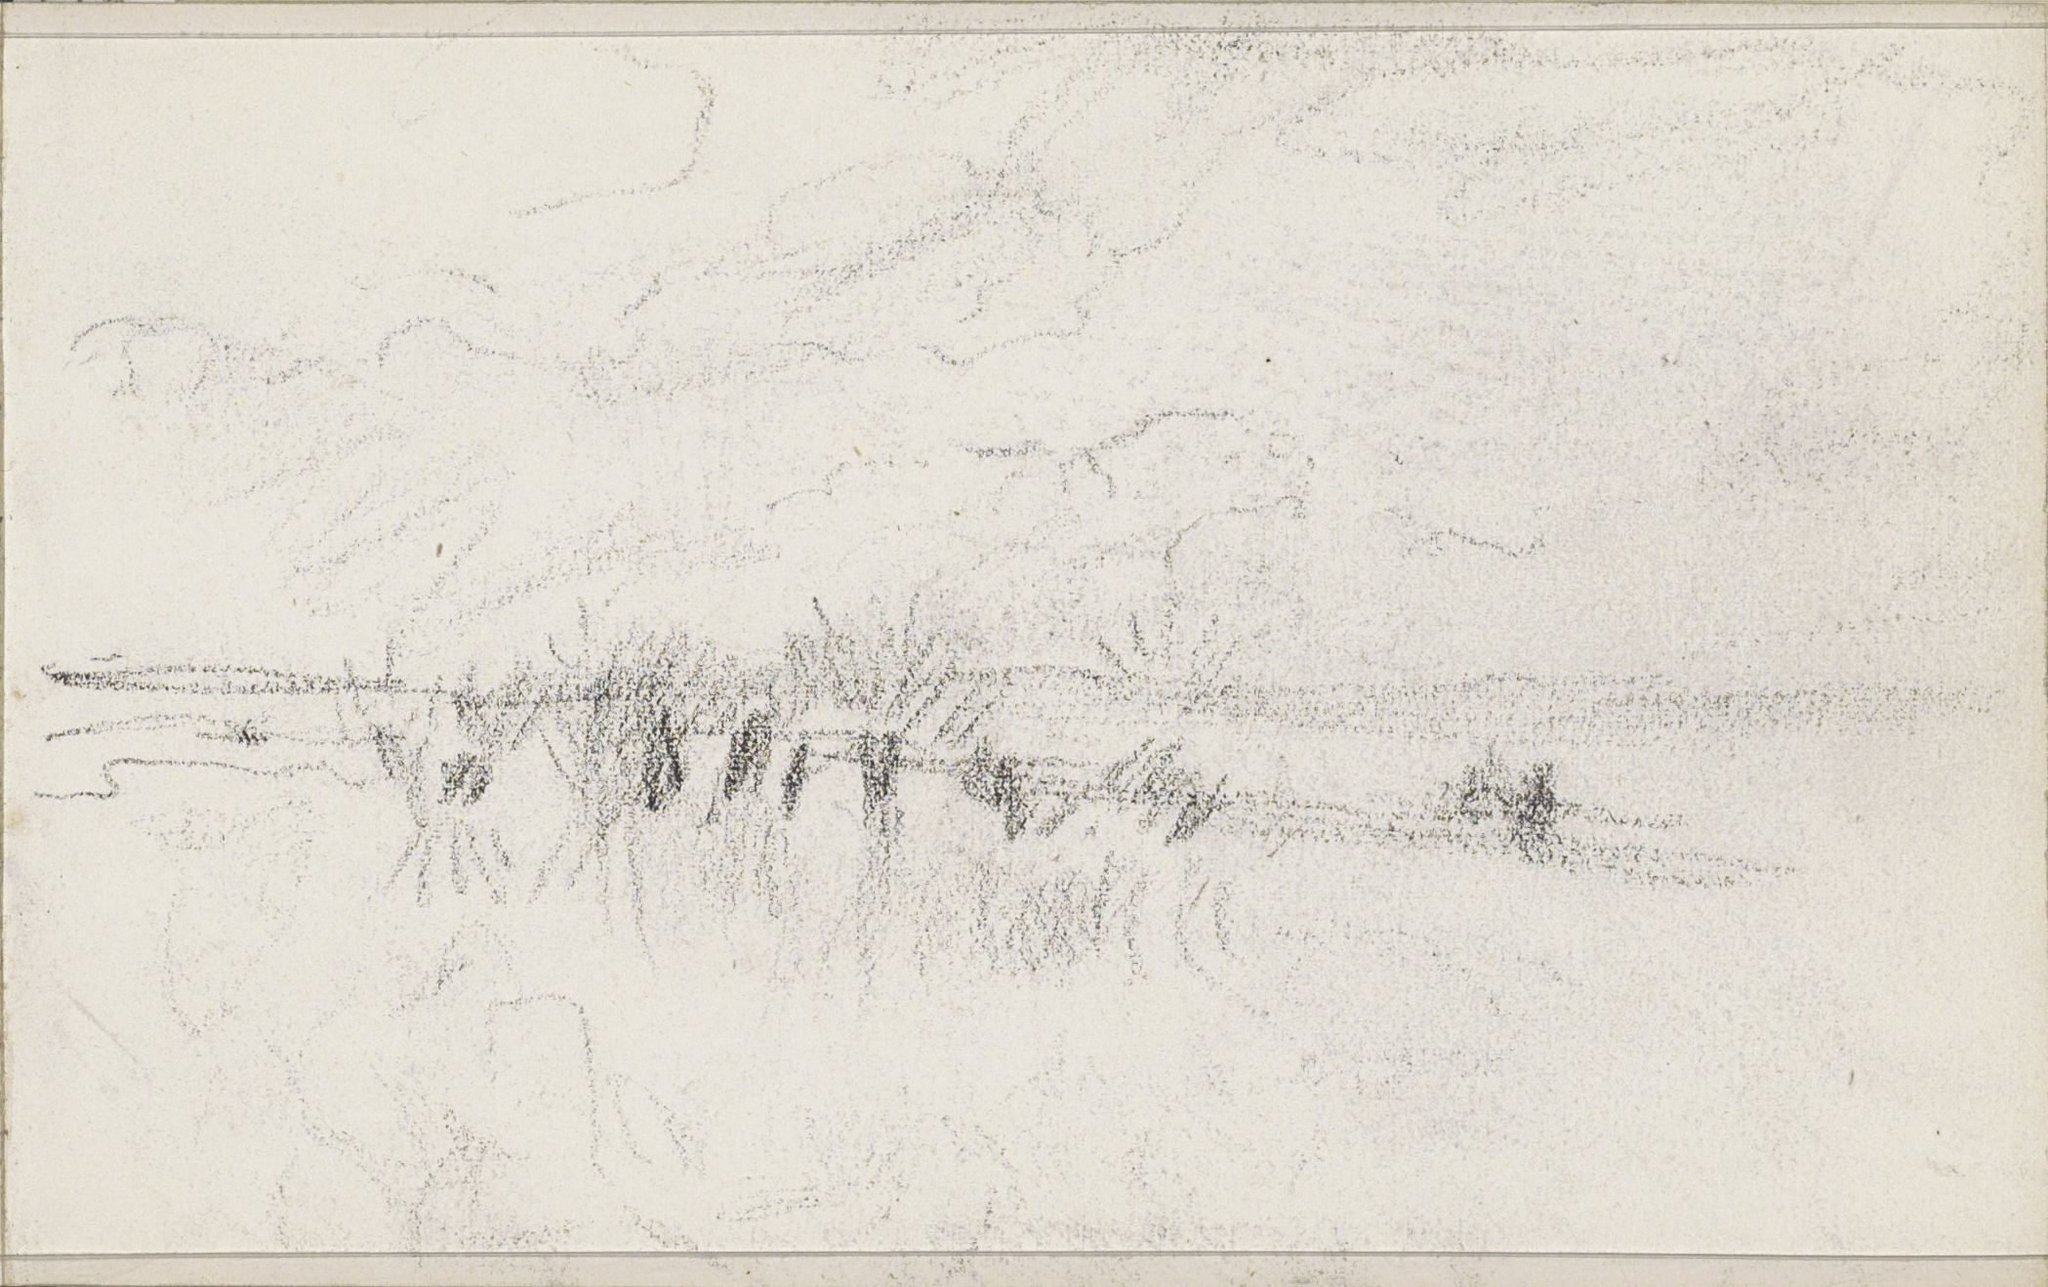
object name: sketchbook leaf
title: Veld met korenschoven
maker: anton mauve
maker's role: draughtsman, painter, print maker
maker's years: 1838-1888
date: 1848-1888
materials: chalk, paper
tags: sheaf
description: Blad 2 recto uit een schetsboek met 43 bladen.